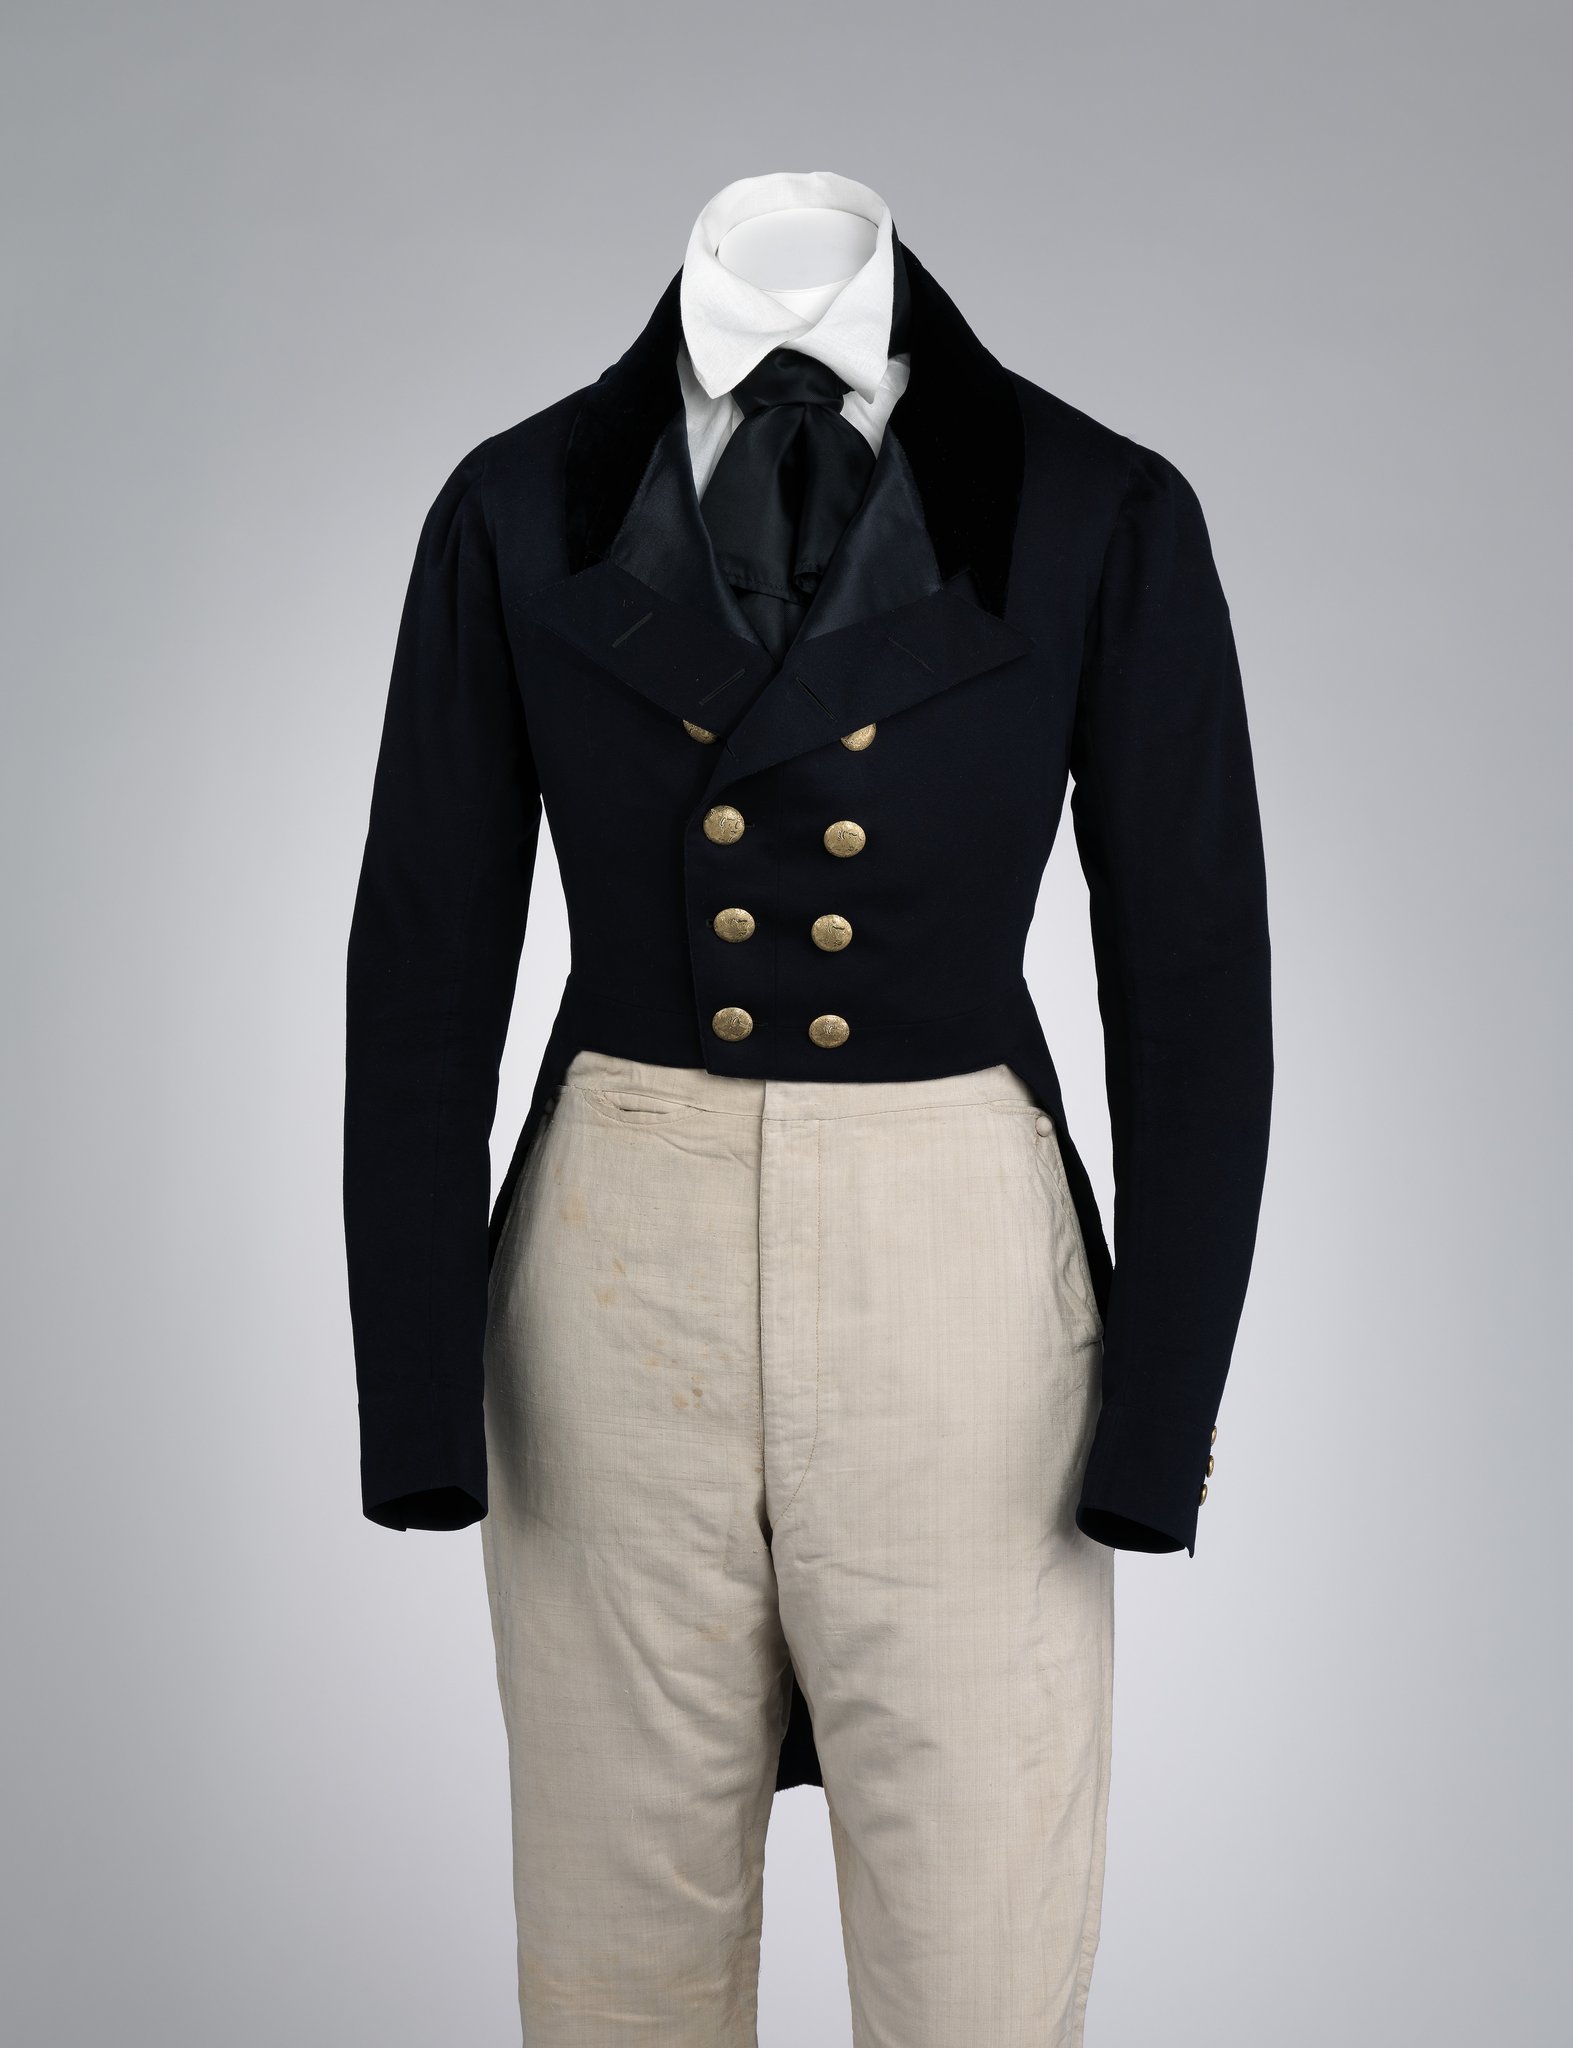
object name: tail coat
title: Tailcoat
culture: british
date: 1840-1850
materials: cotton, metal, silk, wool